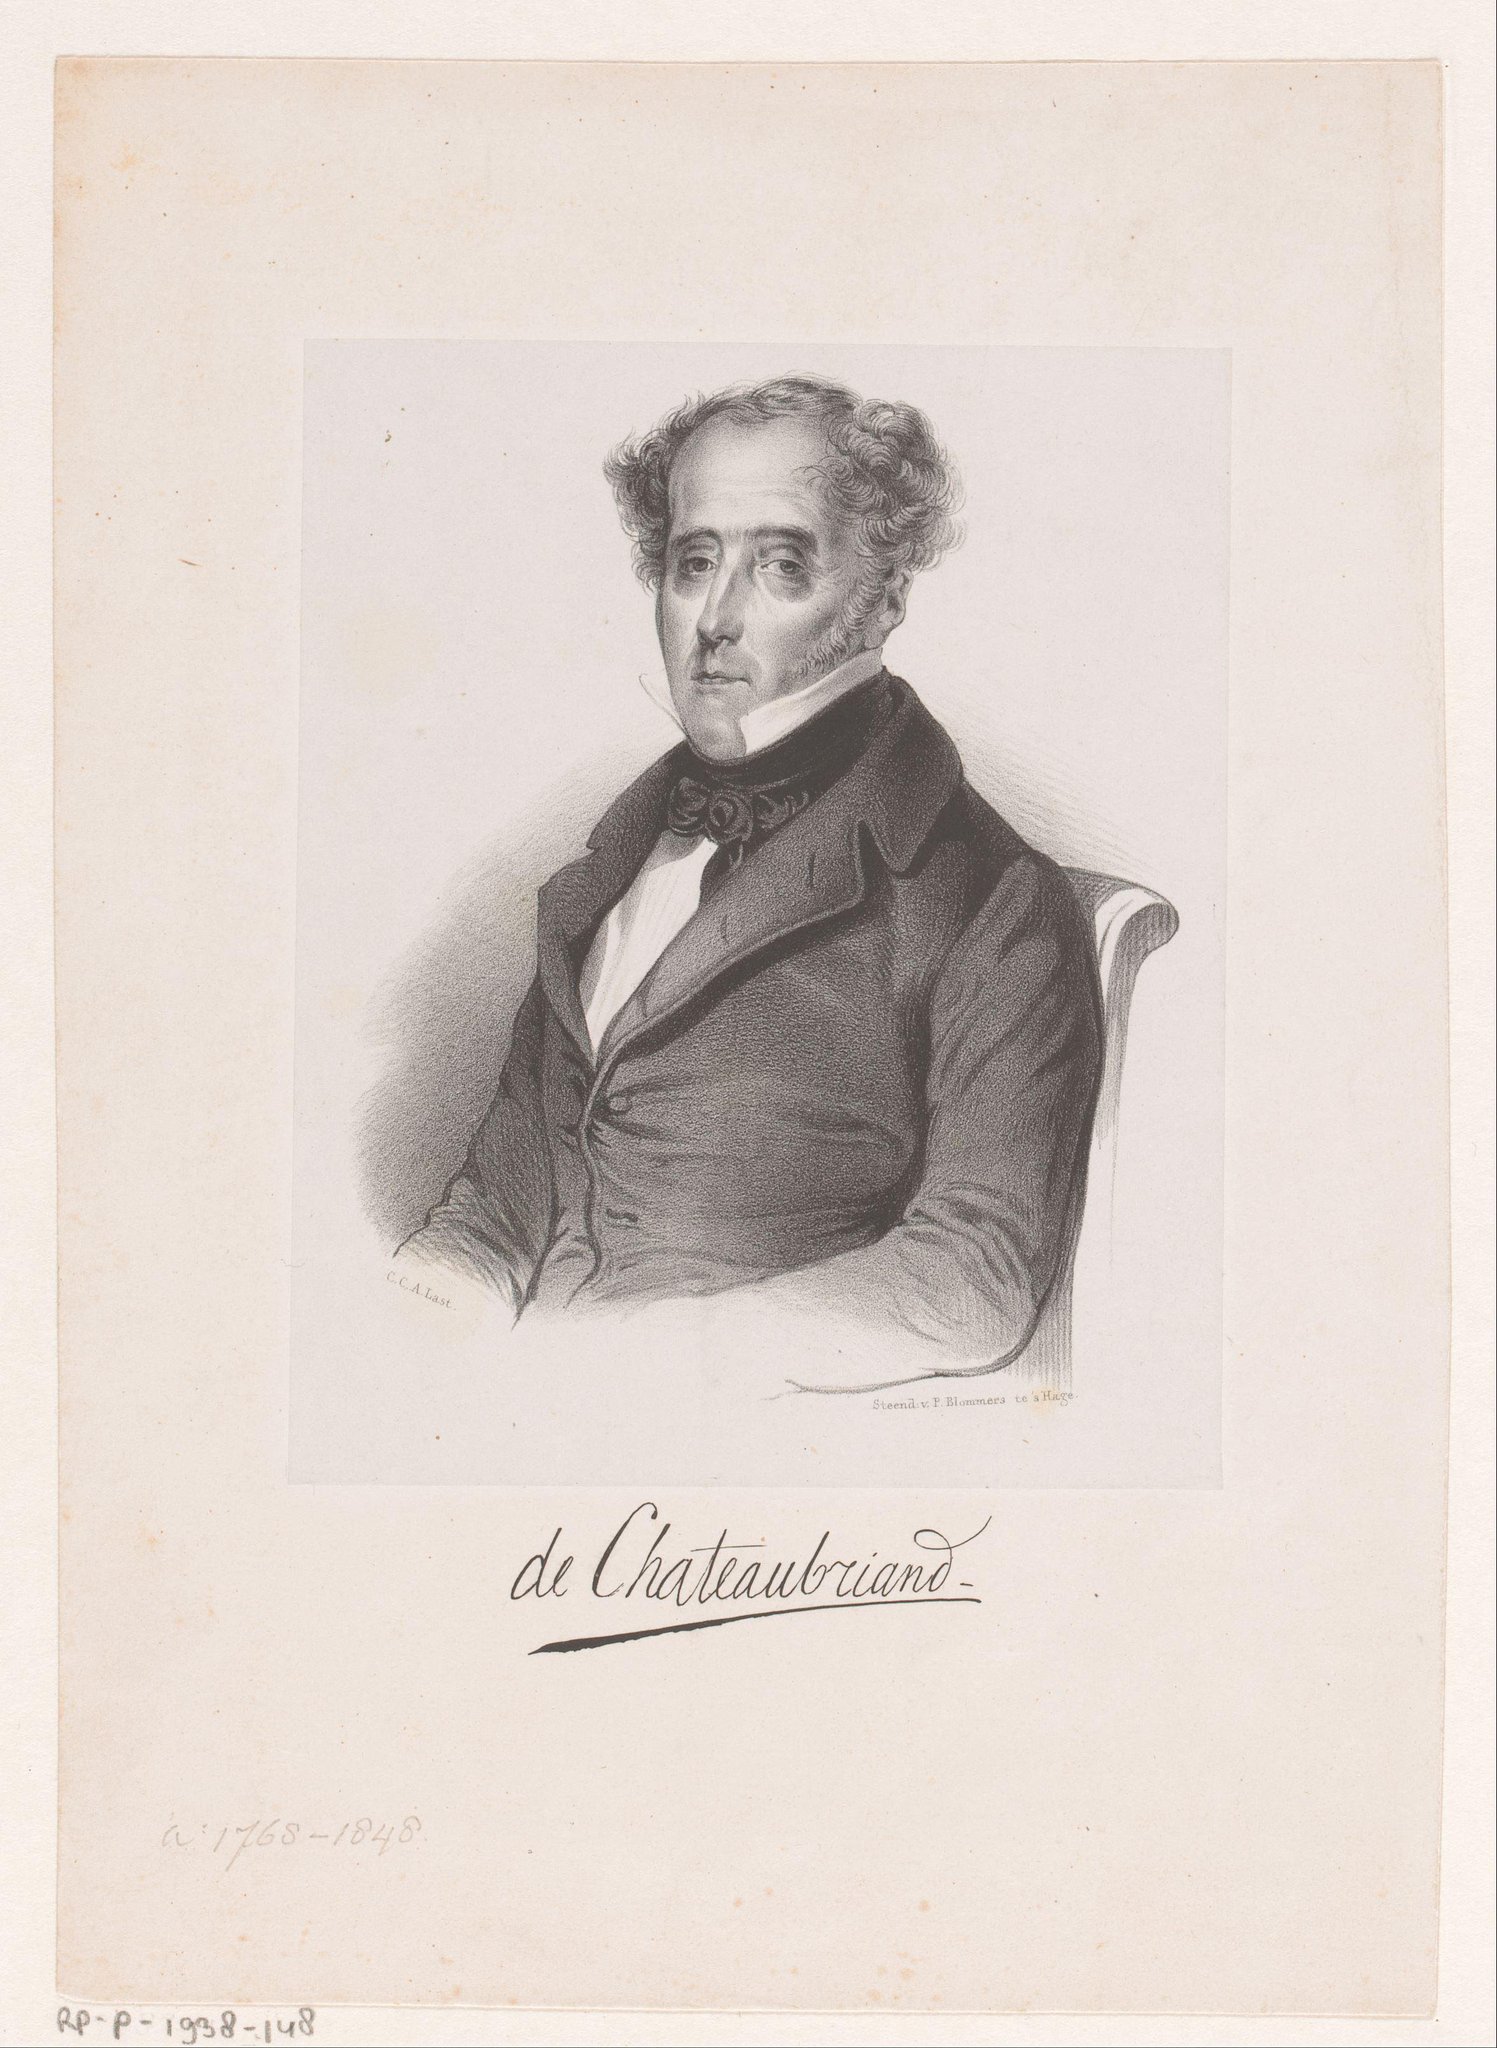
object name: print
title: Portret van François René de Chateaubriand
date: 1842-1887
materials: paper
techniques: lithograph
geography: netherlands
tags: politician, françois-rené de chateaubriand, historical persons (+ (full) bust portrait)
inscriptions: collector's mark: Lugt 2228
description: Onder het portret de signatuur van de geportretteerde.